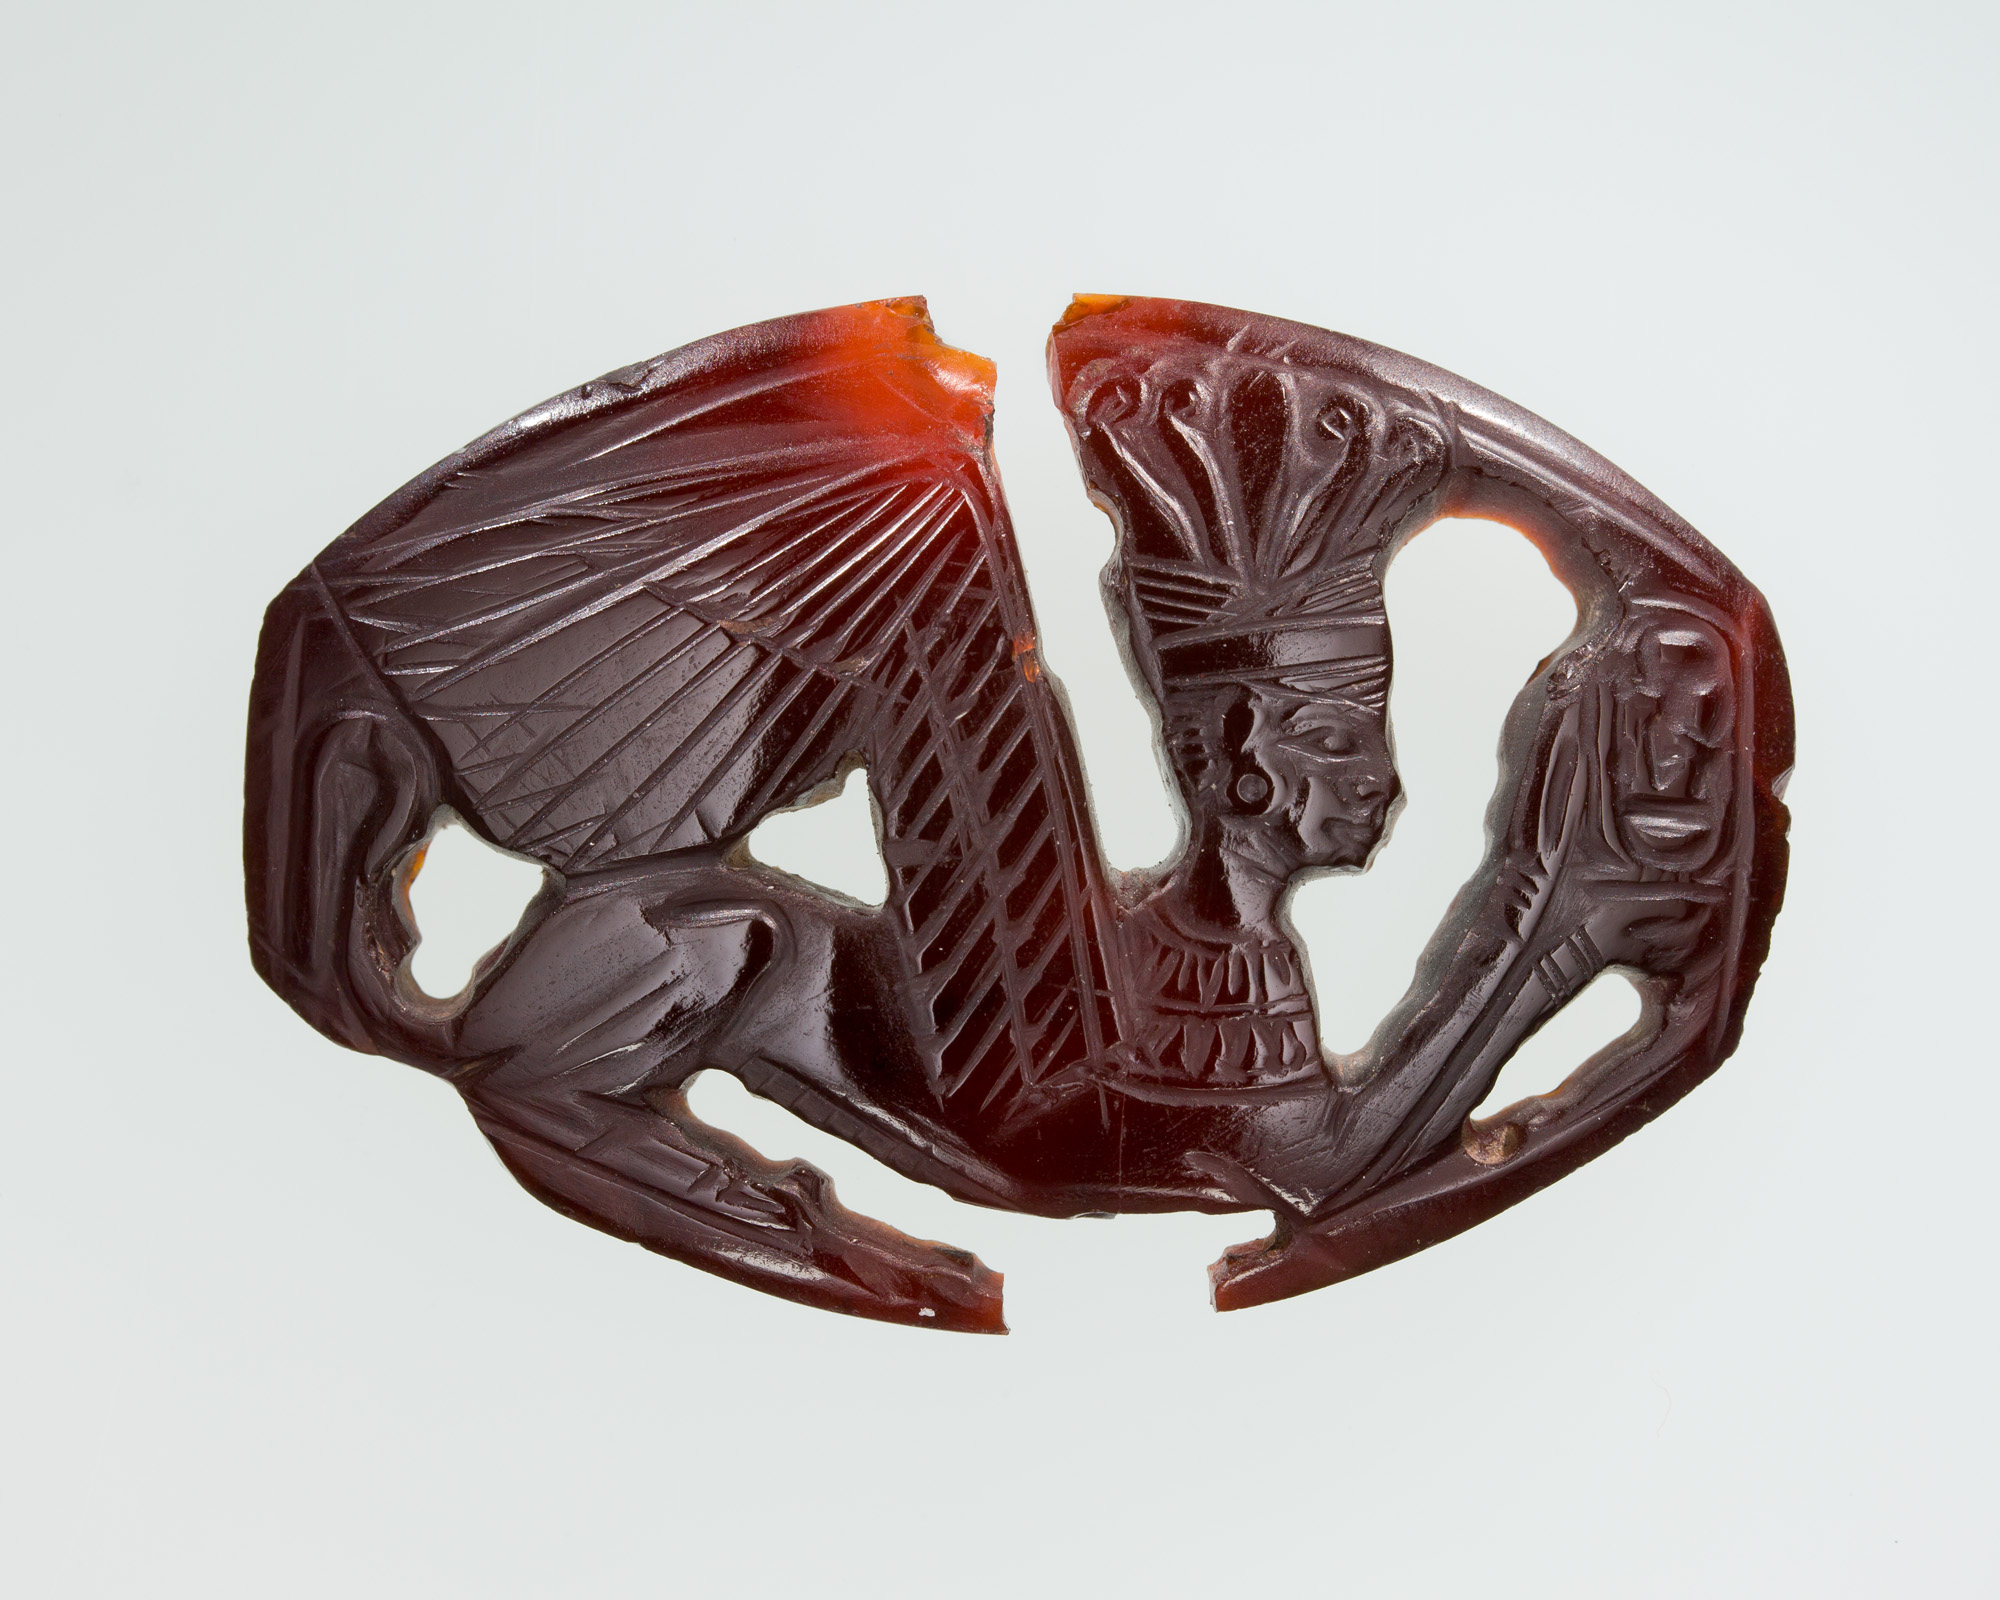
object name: bracelet plaque, female sphinx, nebmaatre, amenhotep iii, tiye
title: Carved Plaque from a Bracelet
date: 1390-1352 BCE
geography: egypt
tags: sphinx